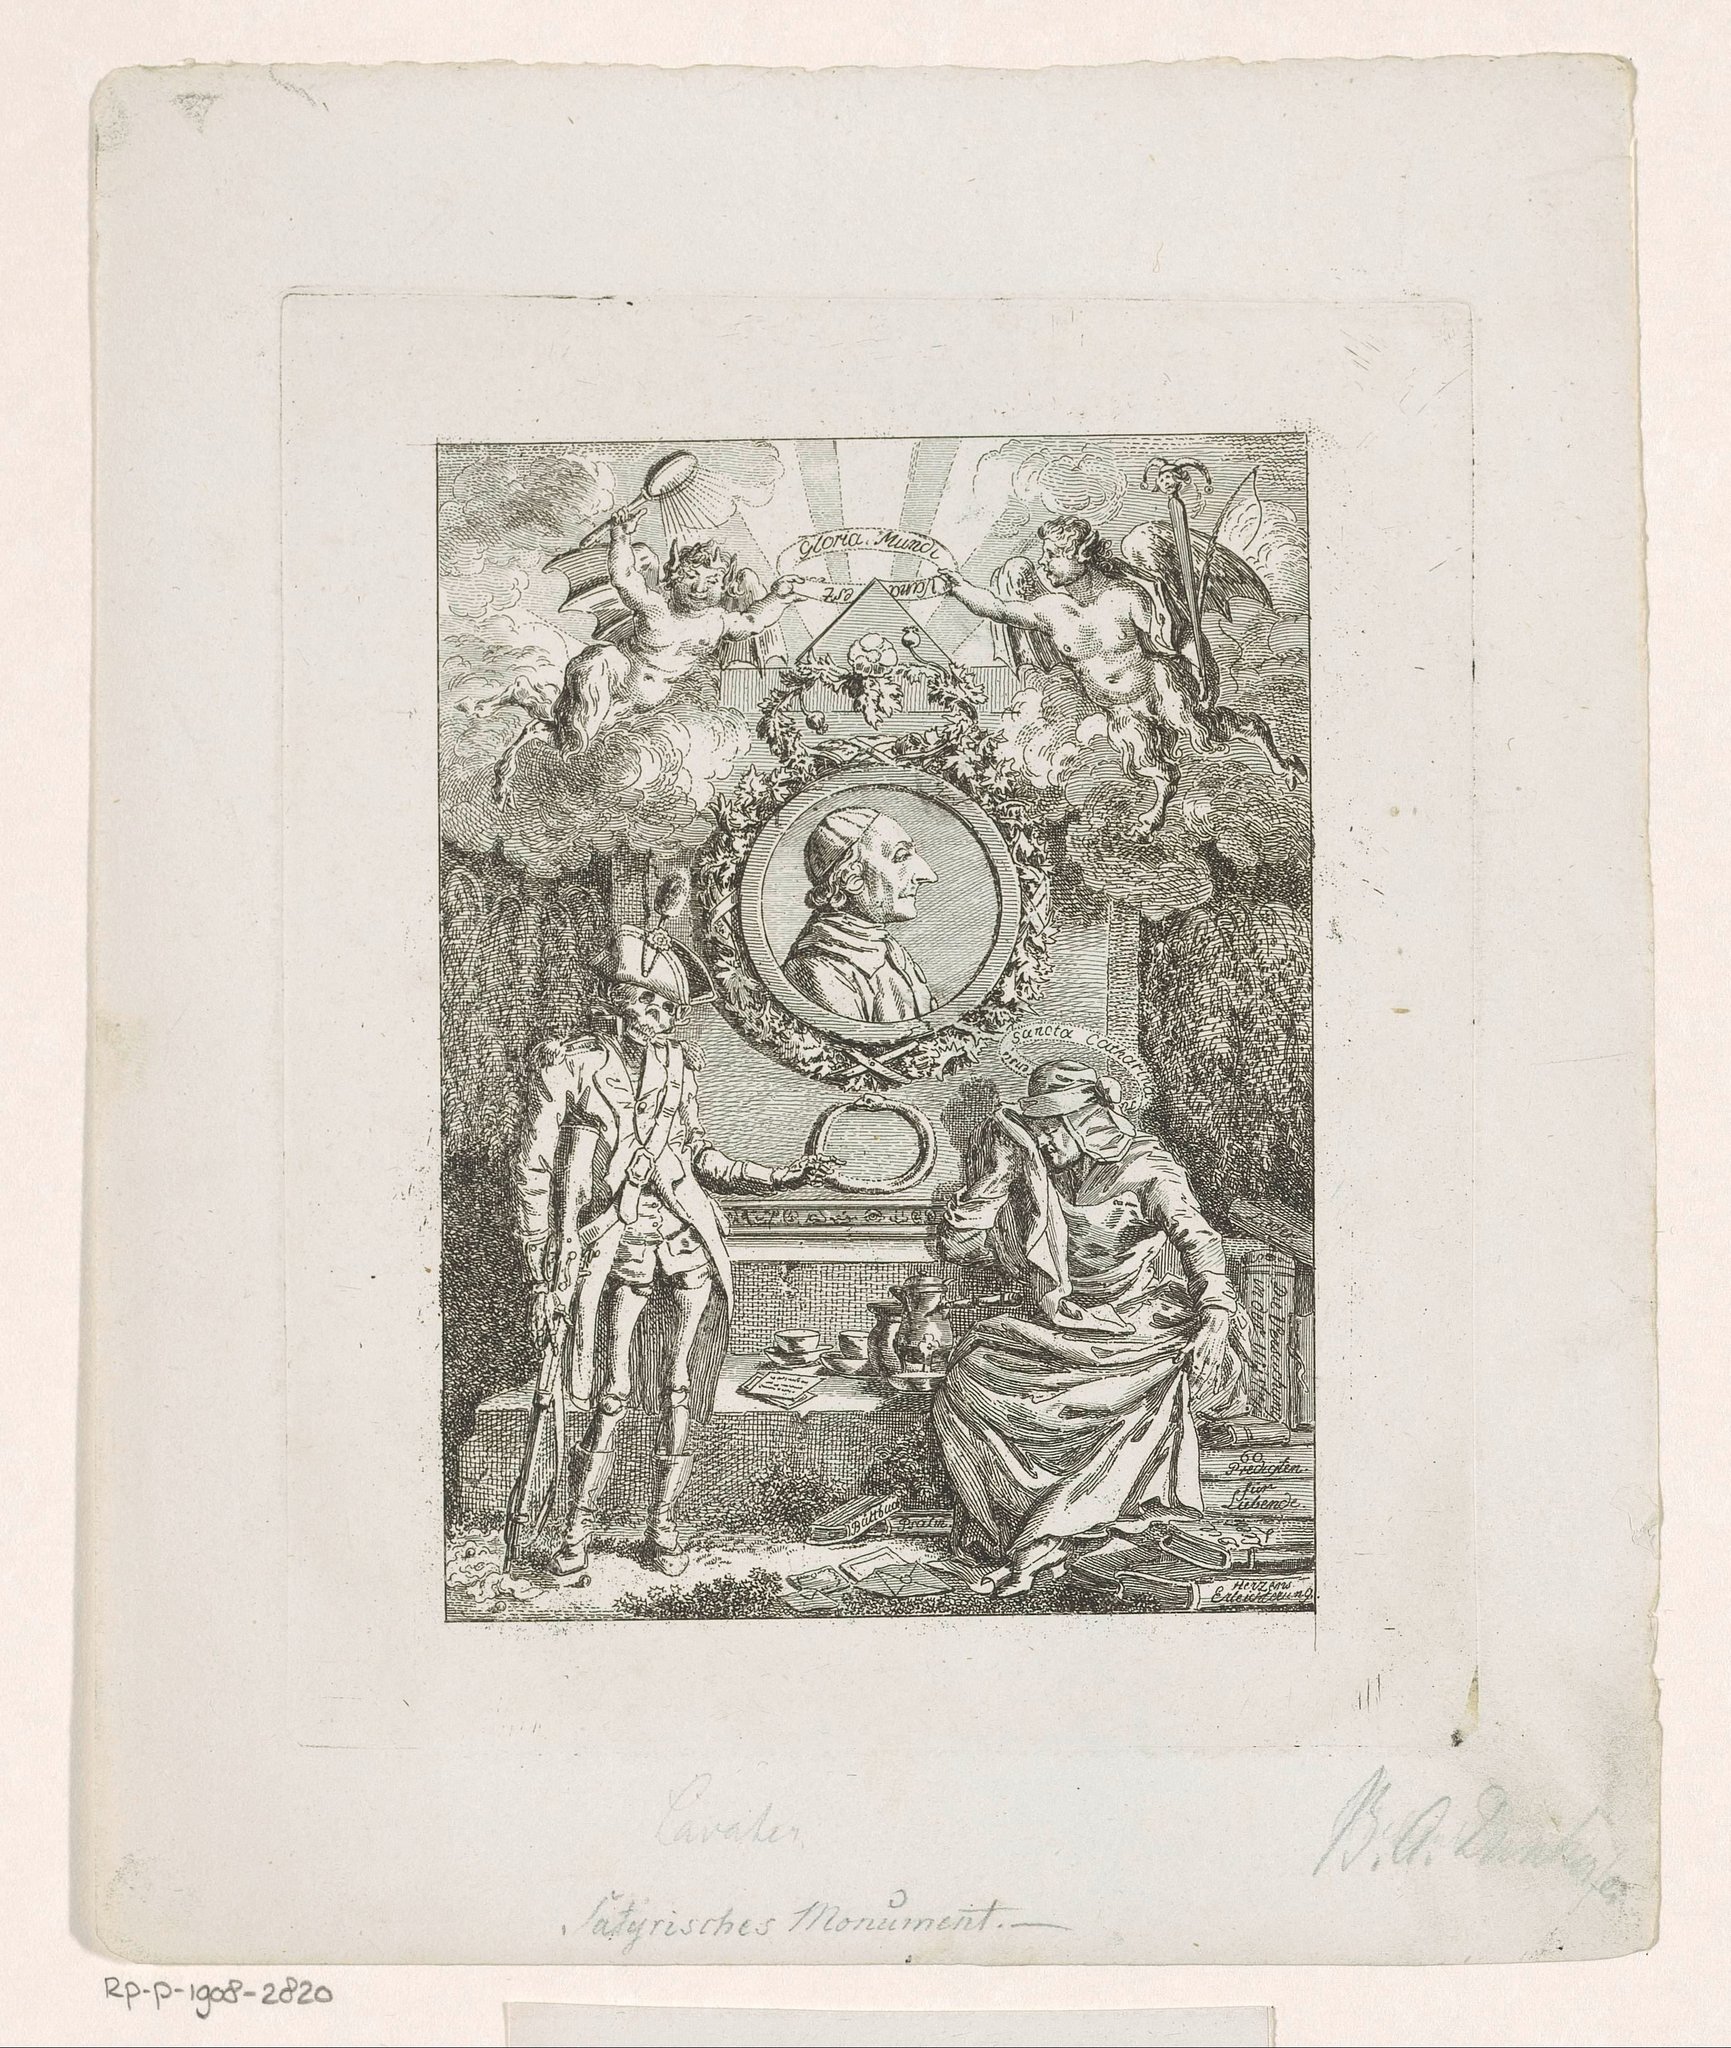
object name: print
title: Satirische allegorie rond het grafmonument van Johann Caspar Lavater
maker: balthasar anton dunker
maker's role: draughtsman, print maker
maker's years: 1746-1807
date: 1801-1807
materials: paper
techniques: etching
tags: johann caspar lavater, garland, wreath, mirror, devils in the form of (fabulous) animals, death as skeleton, historical persons, bauble, the virgin and dominican tertiary, catherine of siena; possible attributes: book, cross, crown of thorns, crucifix, demon under foot, heart (with cross), lily, plague-stricken, ring, rosary, stigmata, book, serpent ouroboros, military clothing and other equipment (uniforms, cap, armour, helmet, etc.), grave, tomb and other grave-forms and grave-markers, crowning the victor with laurel, index finger forwards, pointing, indicating, political caricatures and satires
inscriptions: collector's mark: Lugt 2228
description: Een skelet in uniform wijst naar de heilige Catharina, die huilend op een stapel werken van Lavater zit.